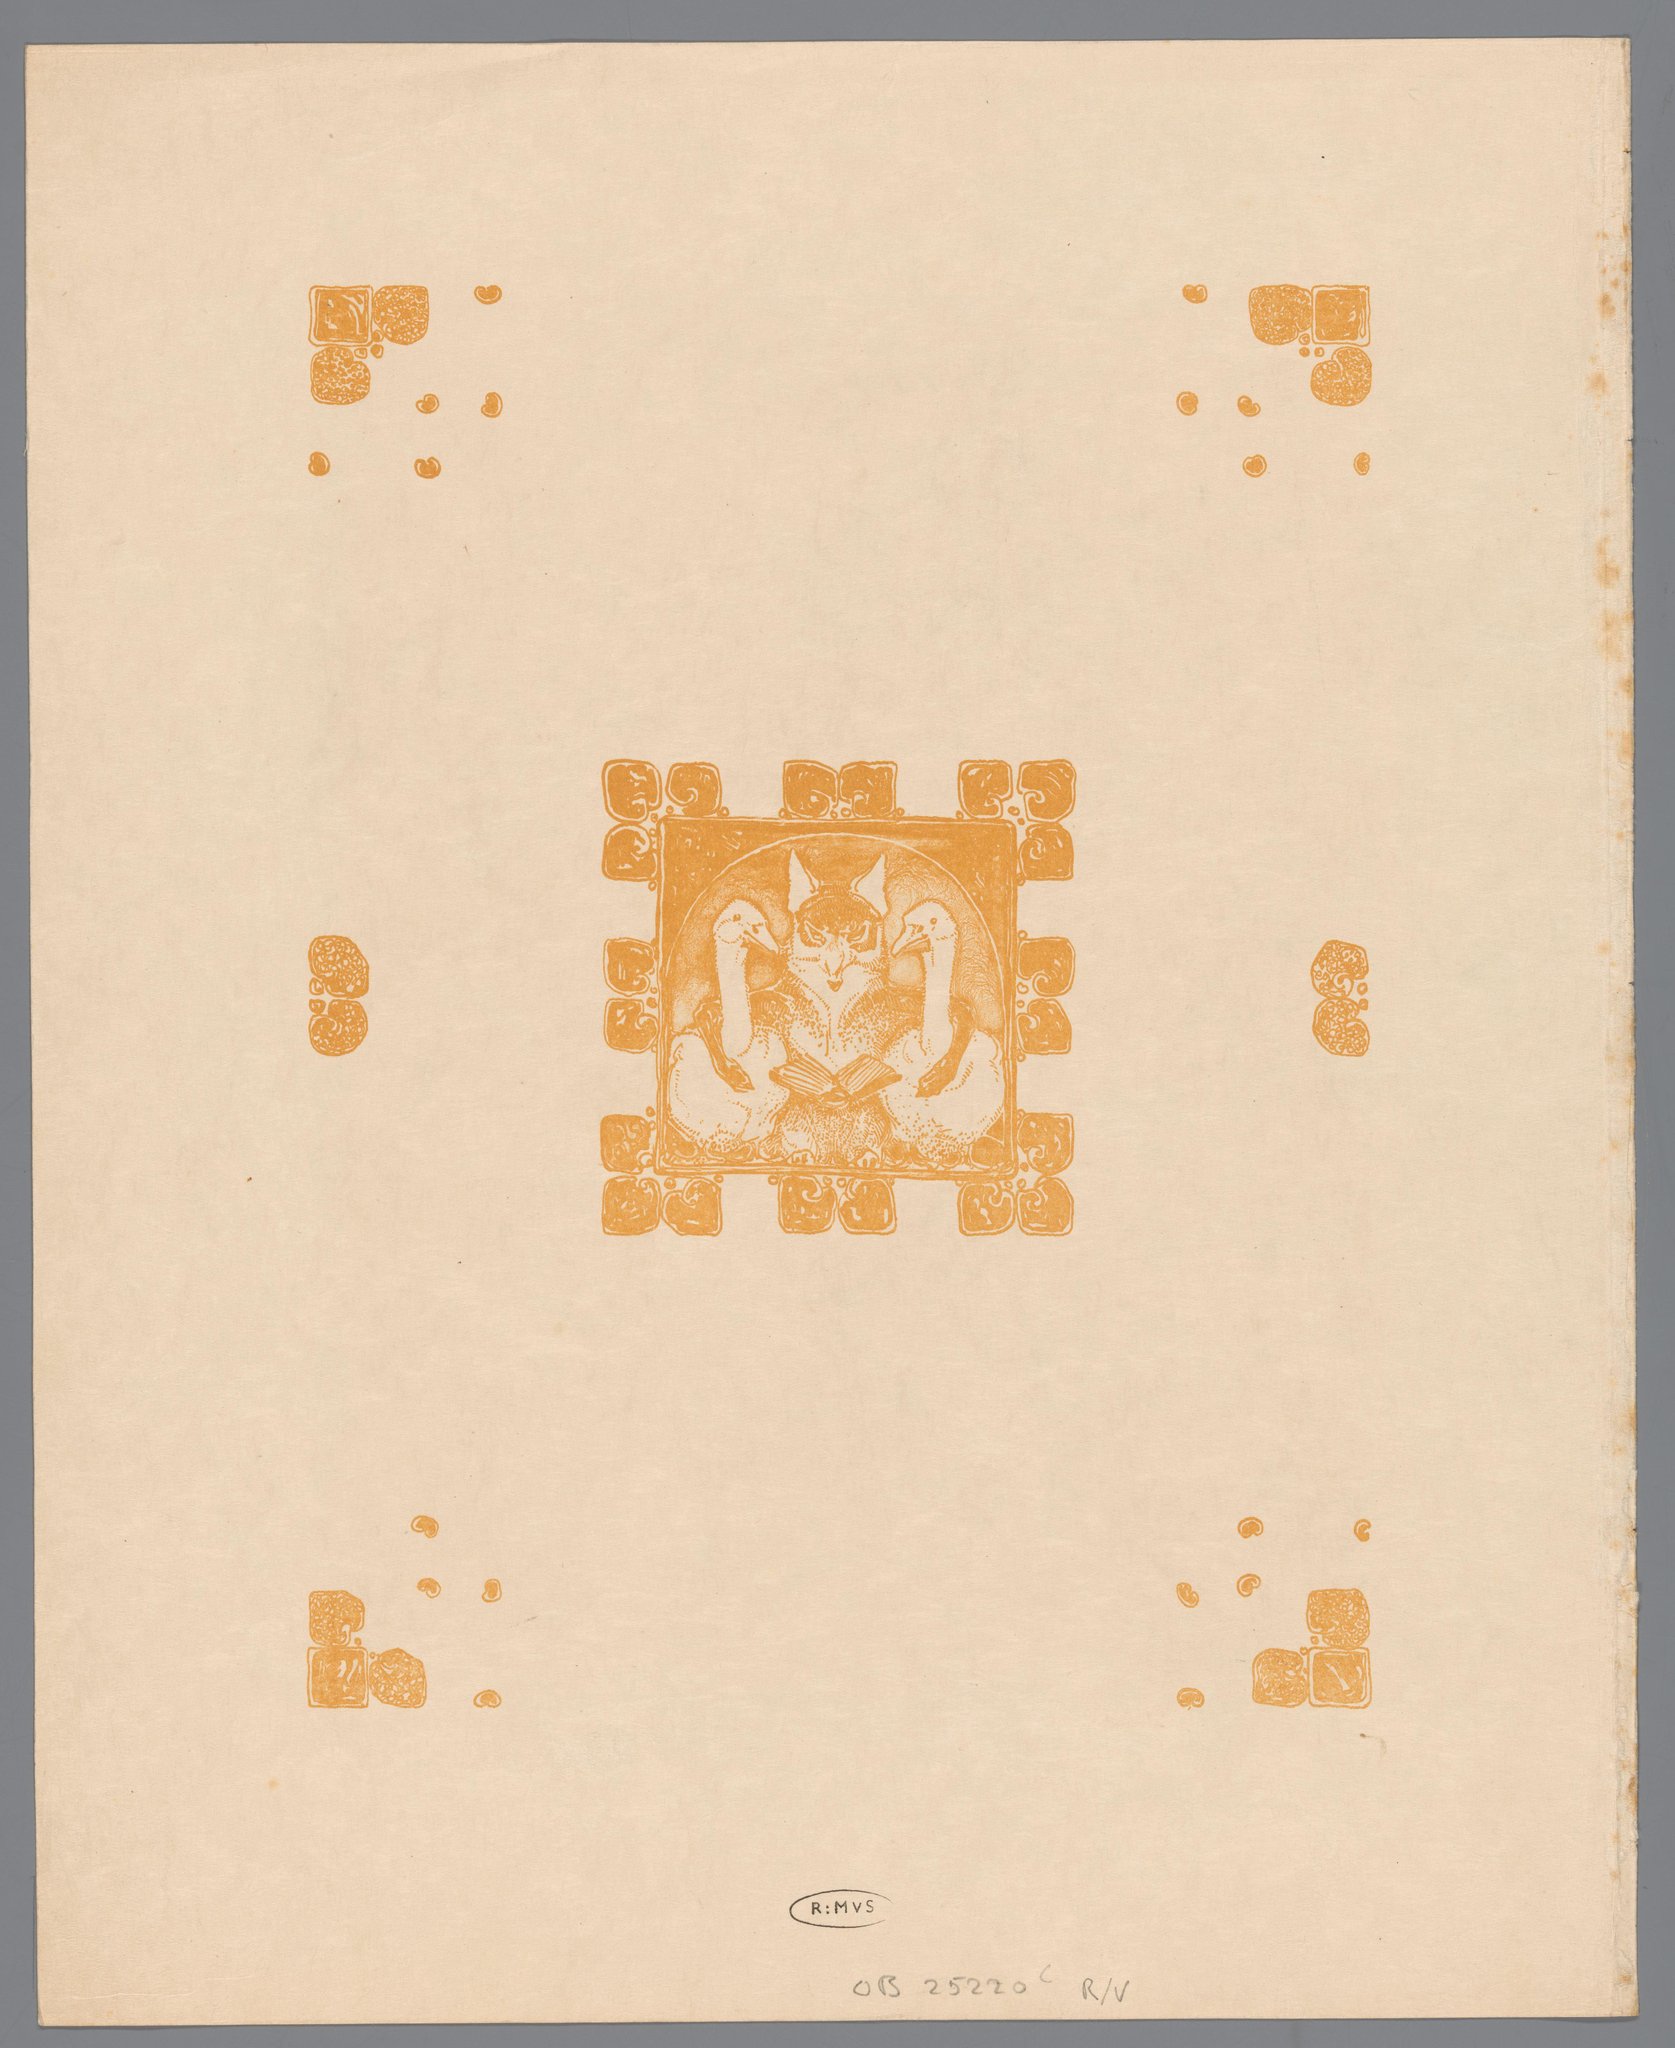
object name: boekillustratie ontwerp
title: Ornamentiek en een vos (Reinaert) met twee ganzen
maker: bernard willem wierink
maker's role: draughtsman, print maker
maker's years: 1856-1939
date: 1910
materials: paper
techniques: lithograph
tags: fable of reynard the fox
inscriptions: collector's mark: Lugt 2228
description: Ontwerp voor: Streuvels, Stijn (Frank Lateur). Reinaert de Vos naar verschillende uitgaven van het middeleeuwsche epos. Amsterdam: L.J. Veen, 1910.